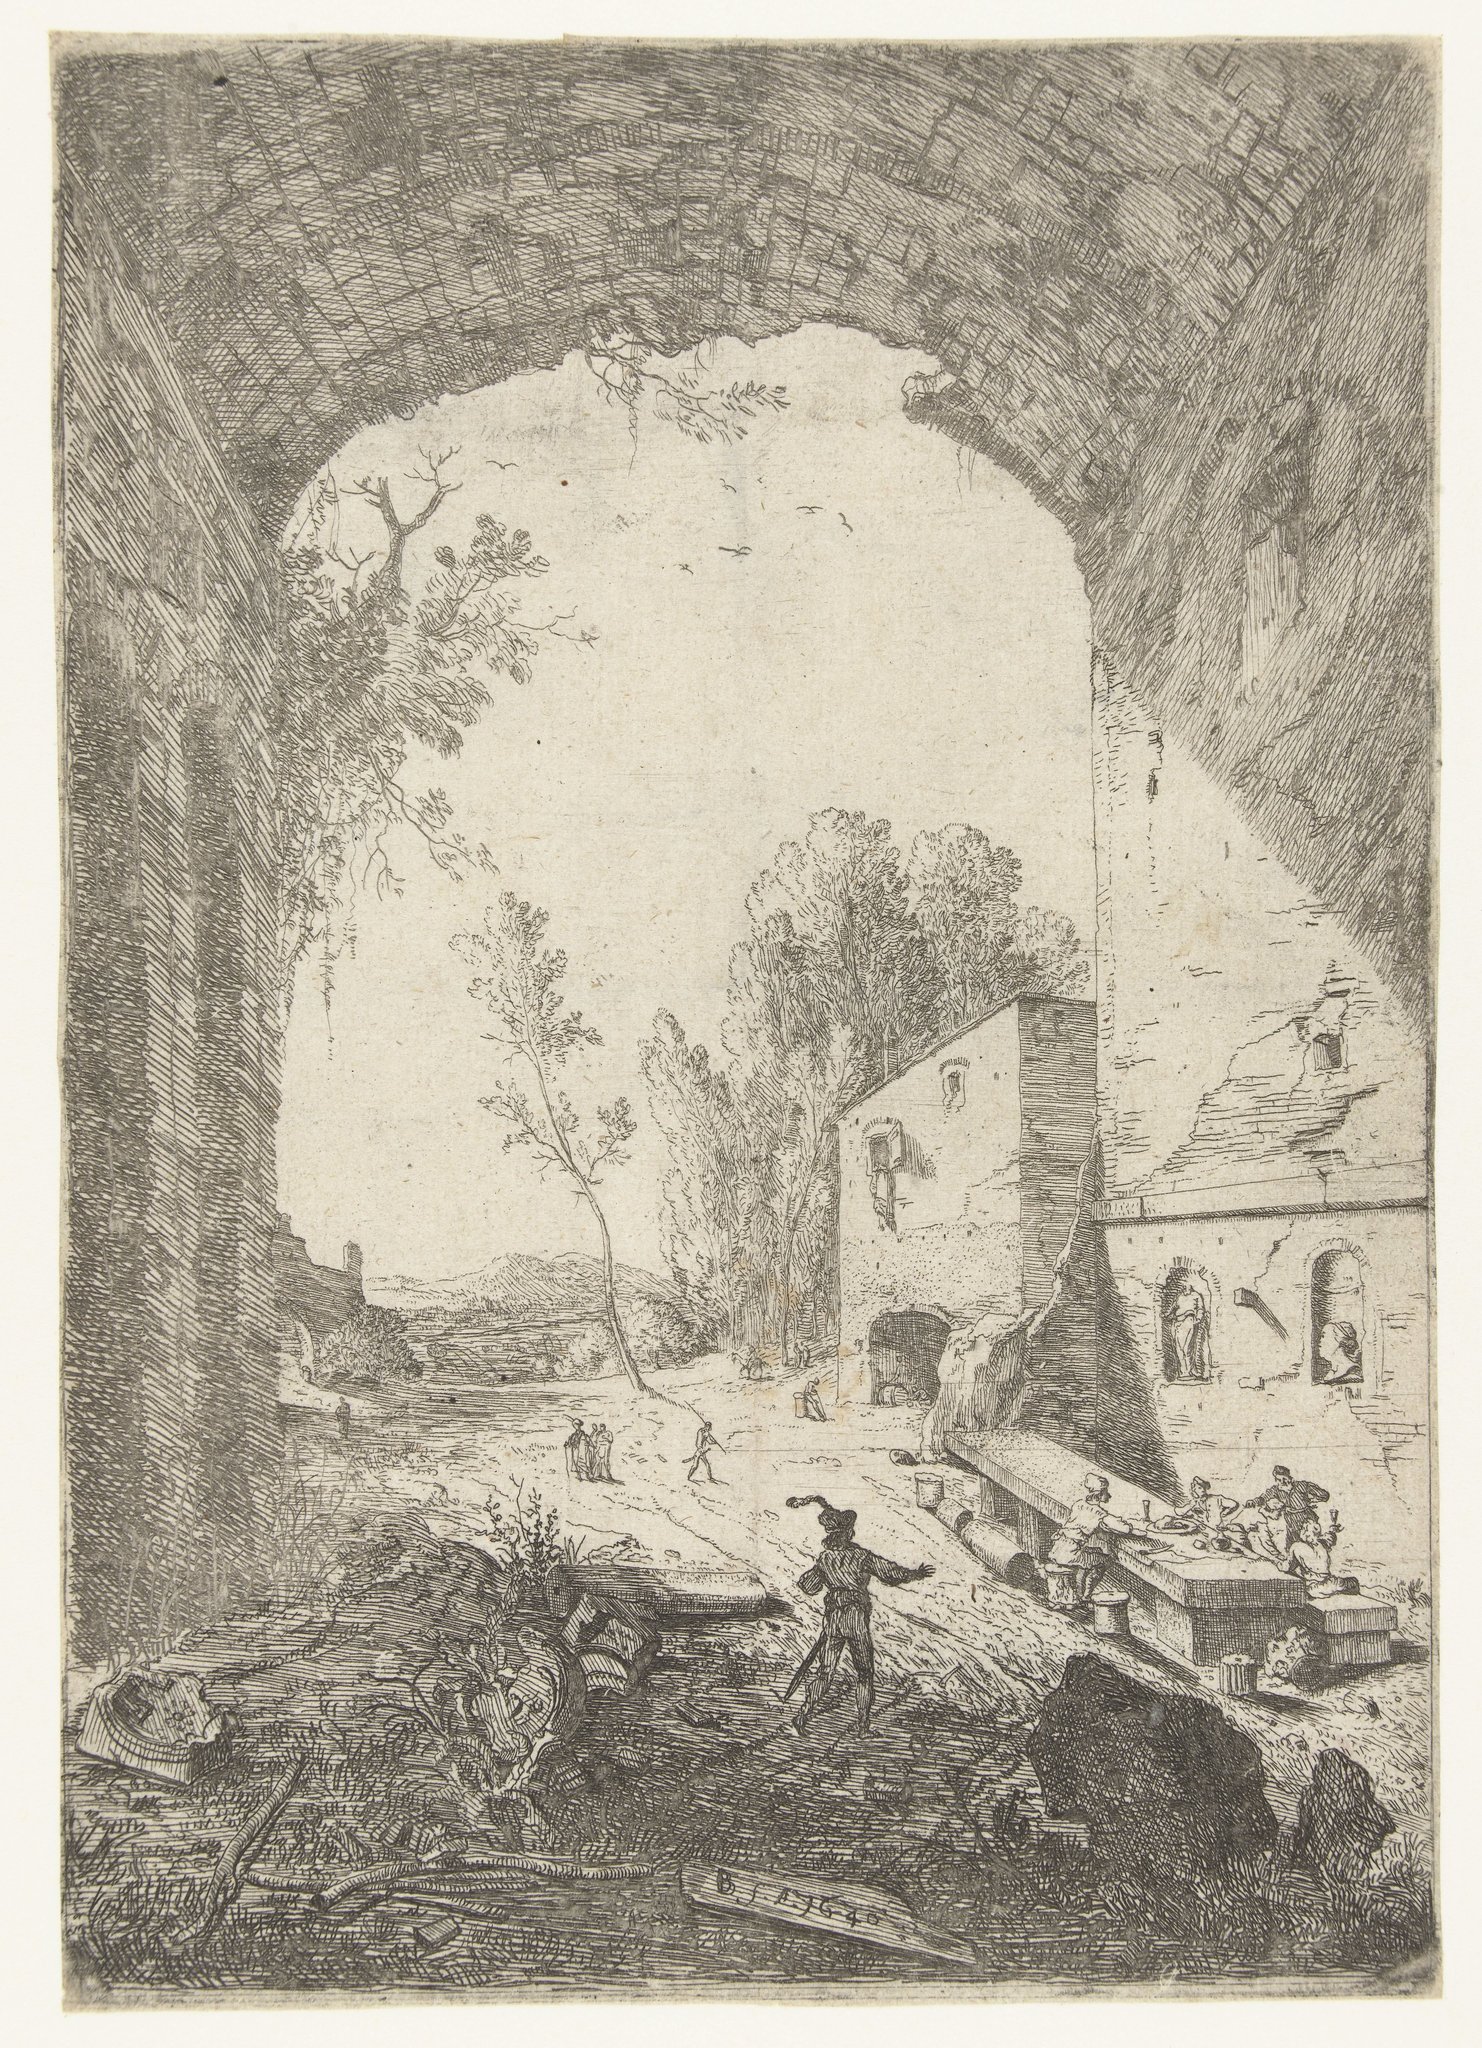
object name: print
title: Herberg bij de Grotta della Ninfa Egeria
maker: bartholomeus breenbergh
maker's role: draughtsman, print maker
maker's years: 1599-1657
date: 1640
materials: paper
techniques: etching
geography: netherlands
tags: inn, coffee-house, public house, etc.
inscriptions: collector's mark: Lugt 240